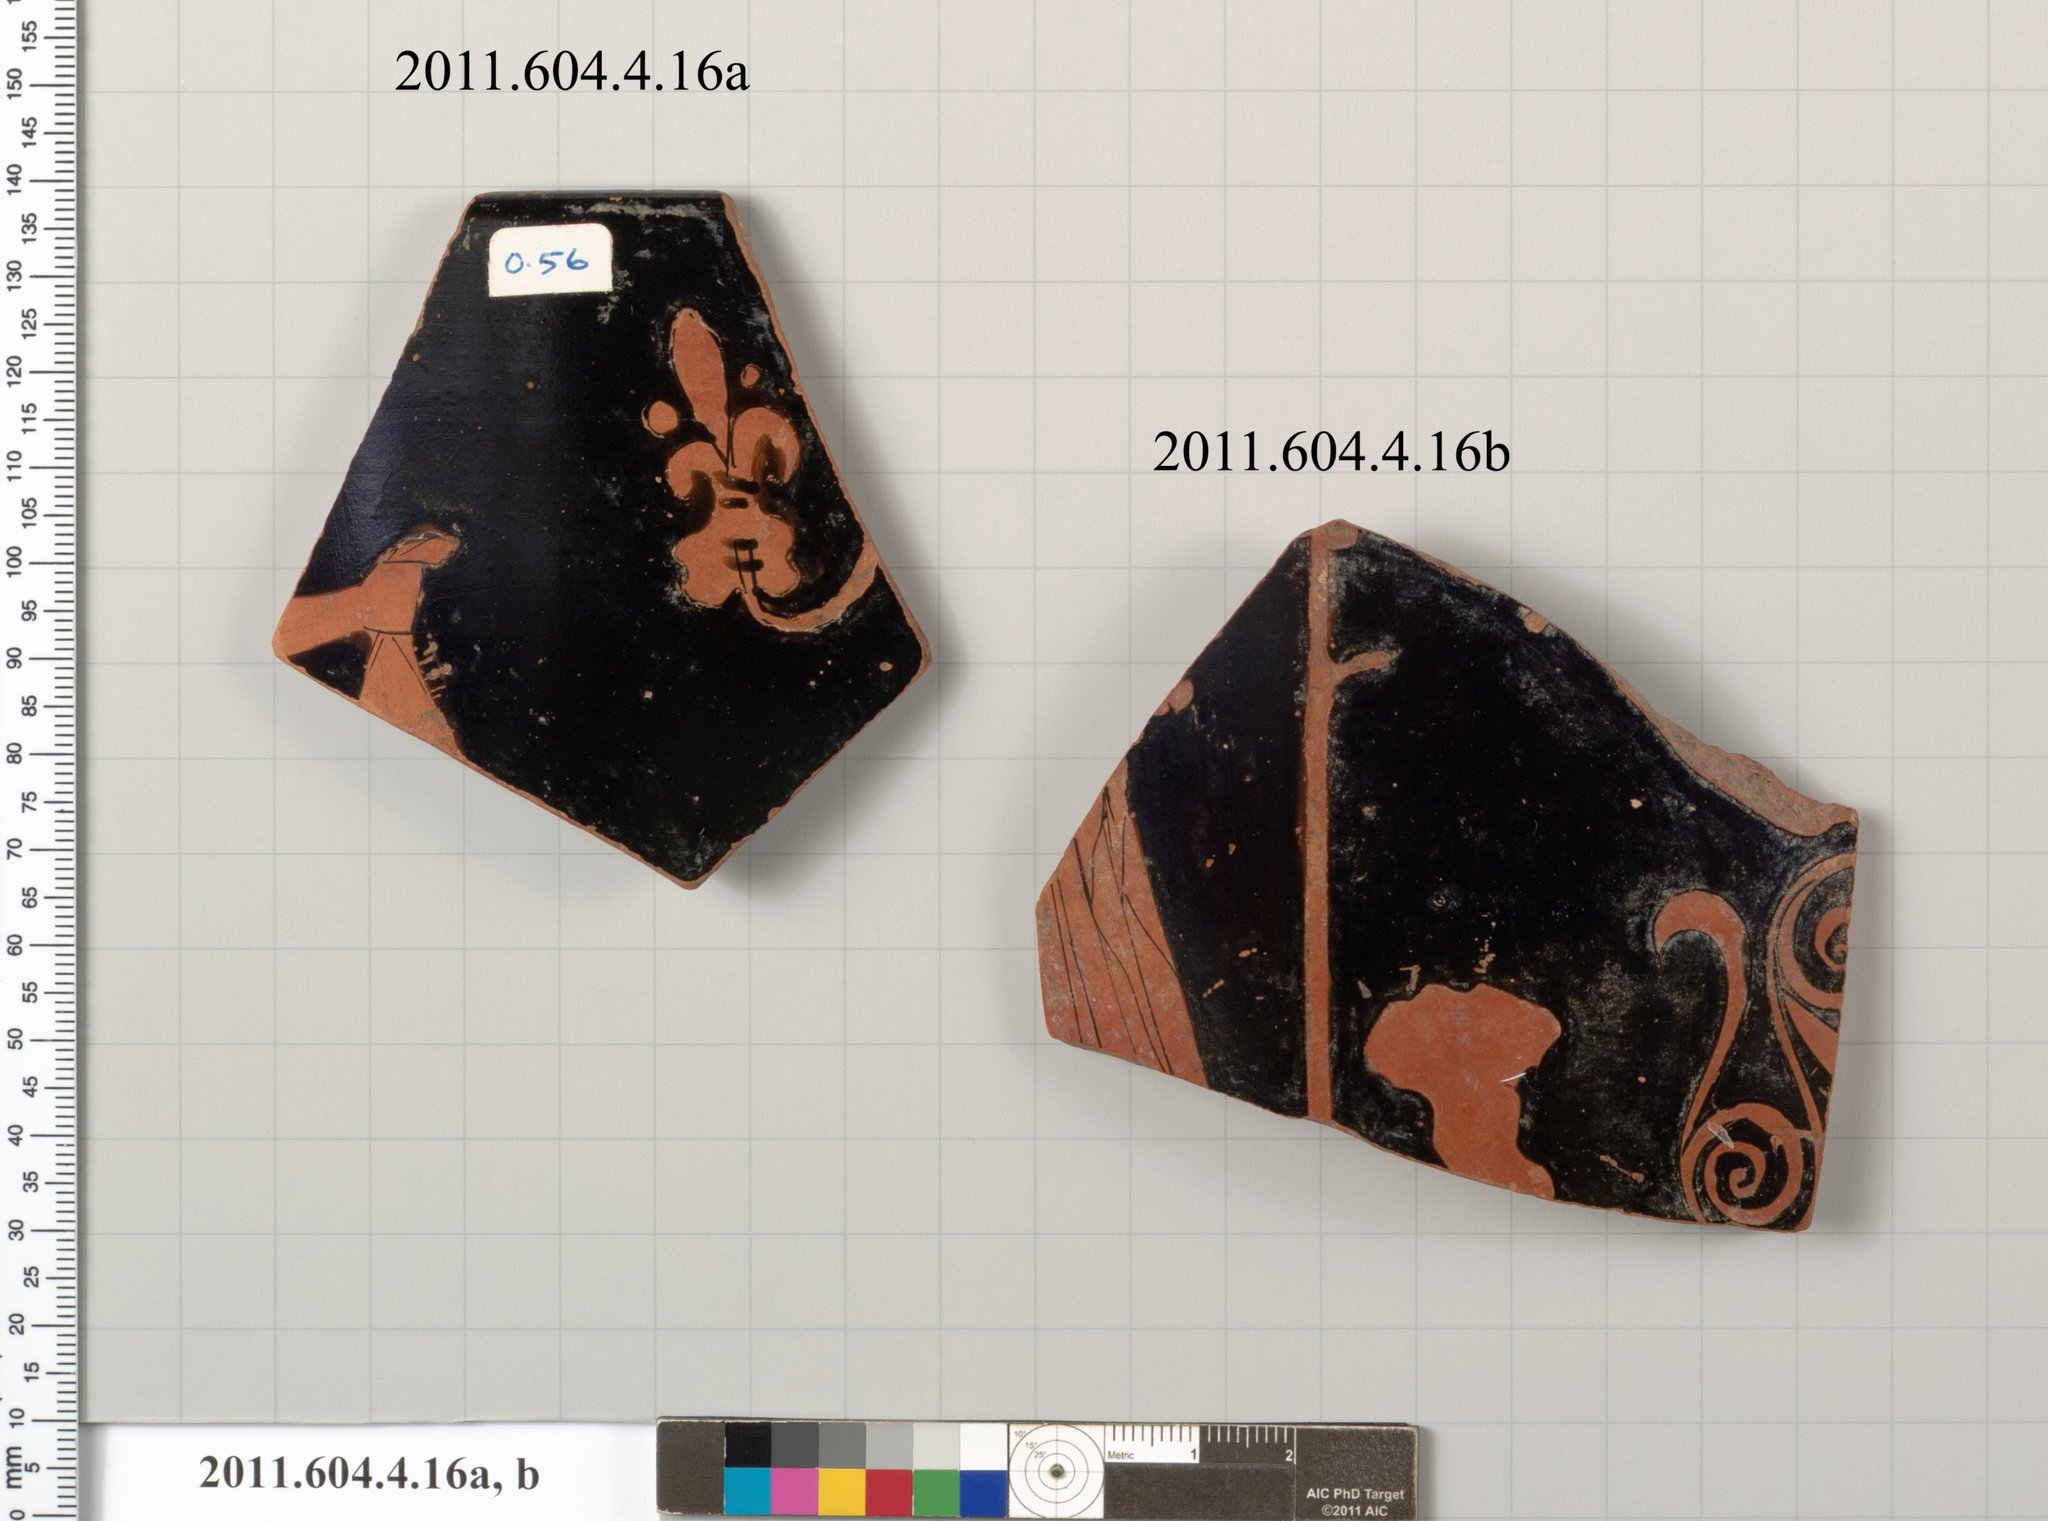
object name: skyphos fragment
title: Terracotta fragments of a skyphos (deep drinking cup)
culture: greek, attic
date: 467-435 BCE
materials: terracotta